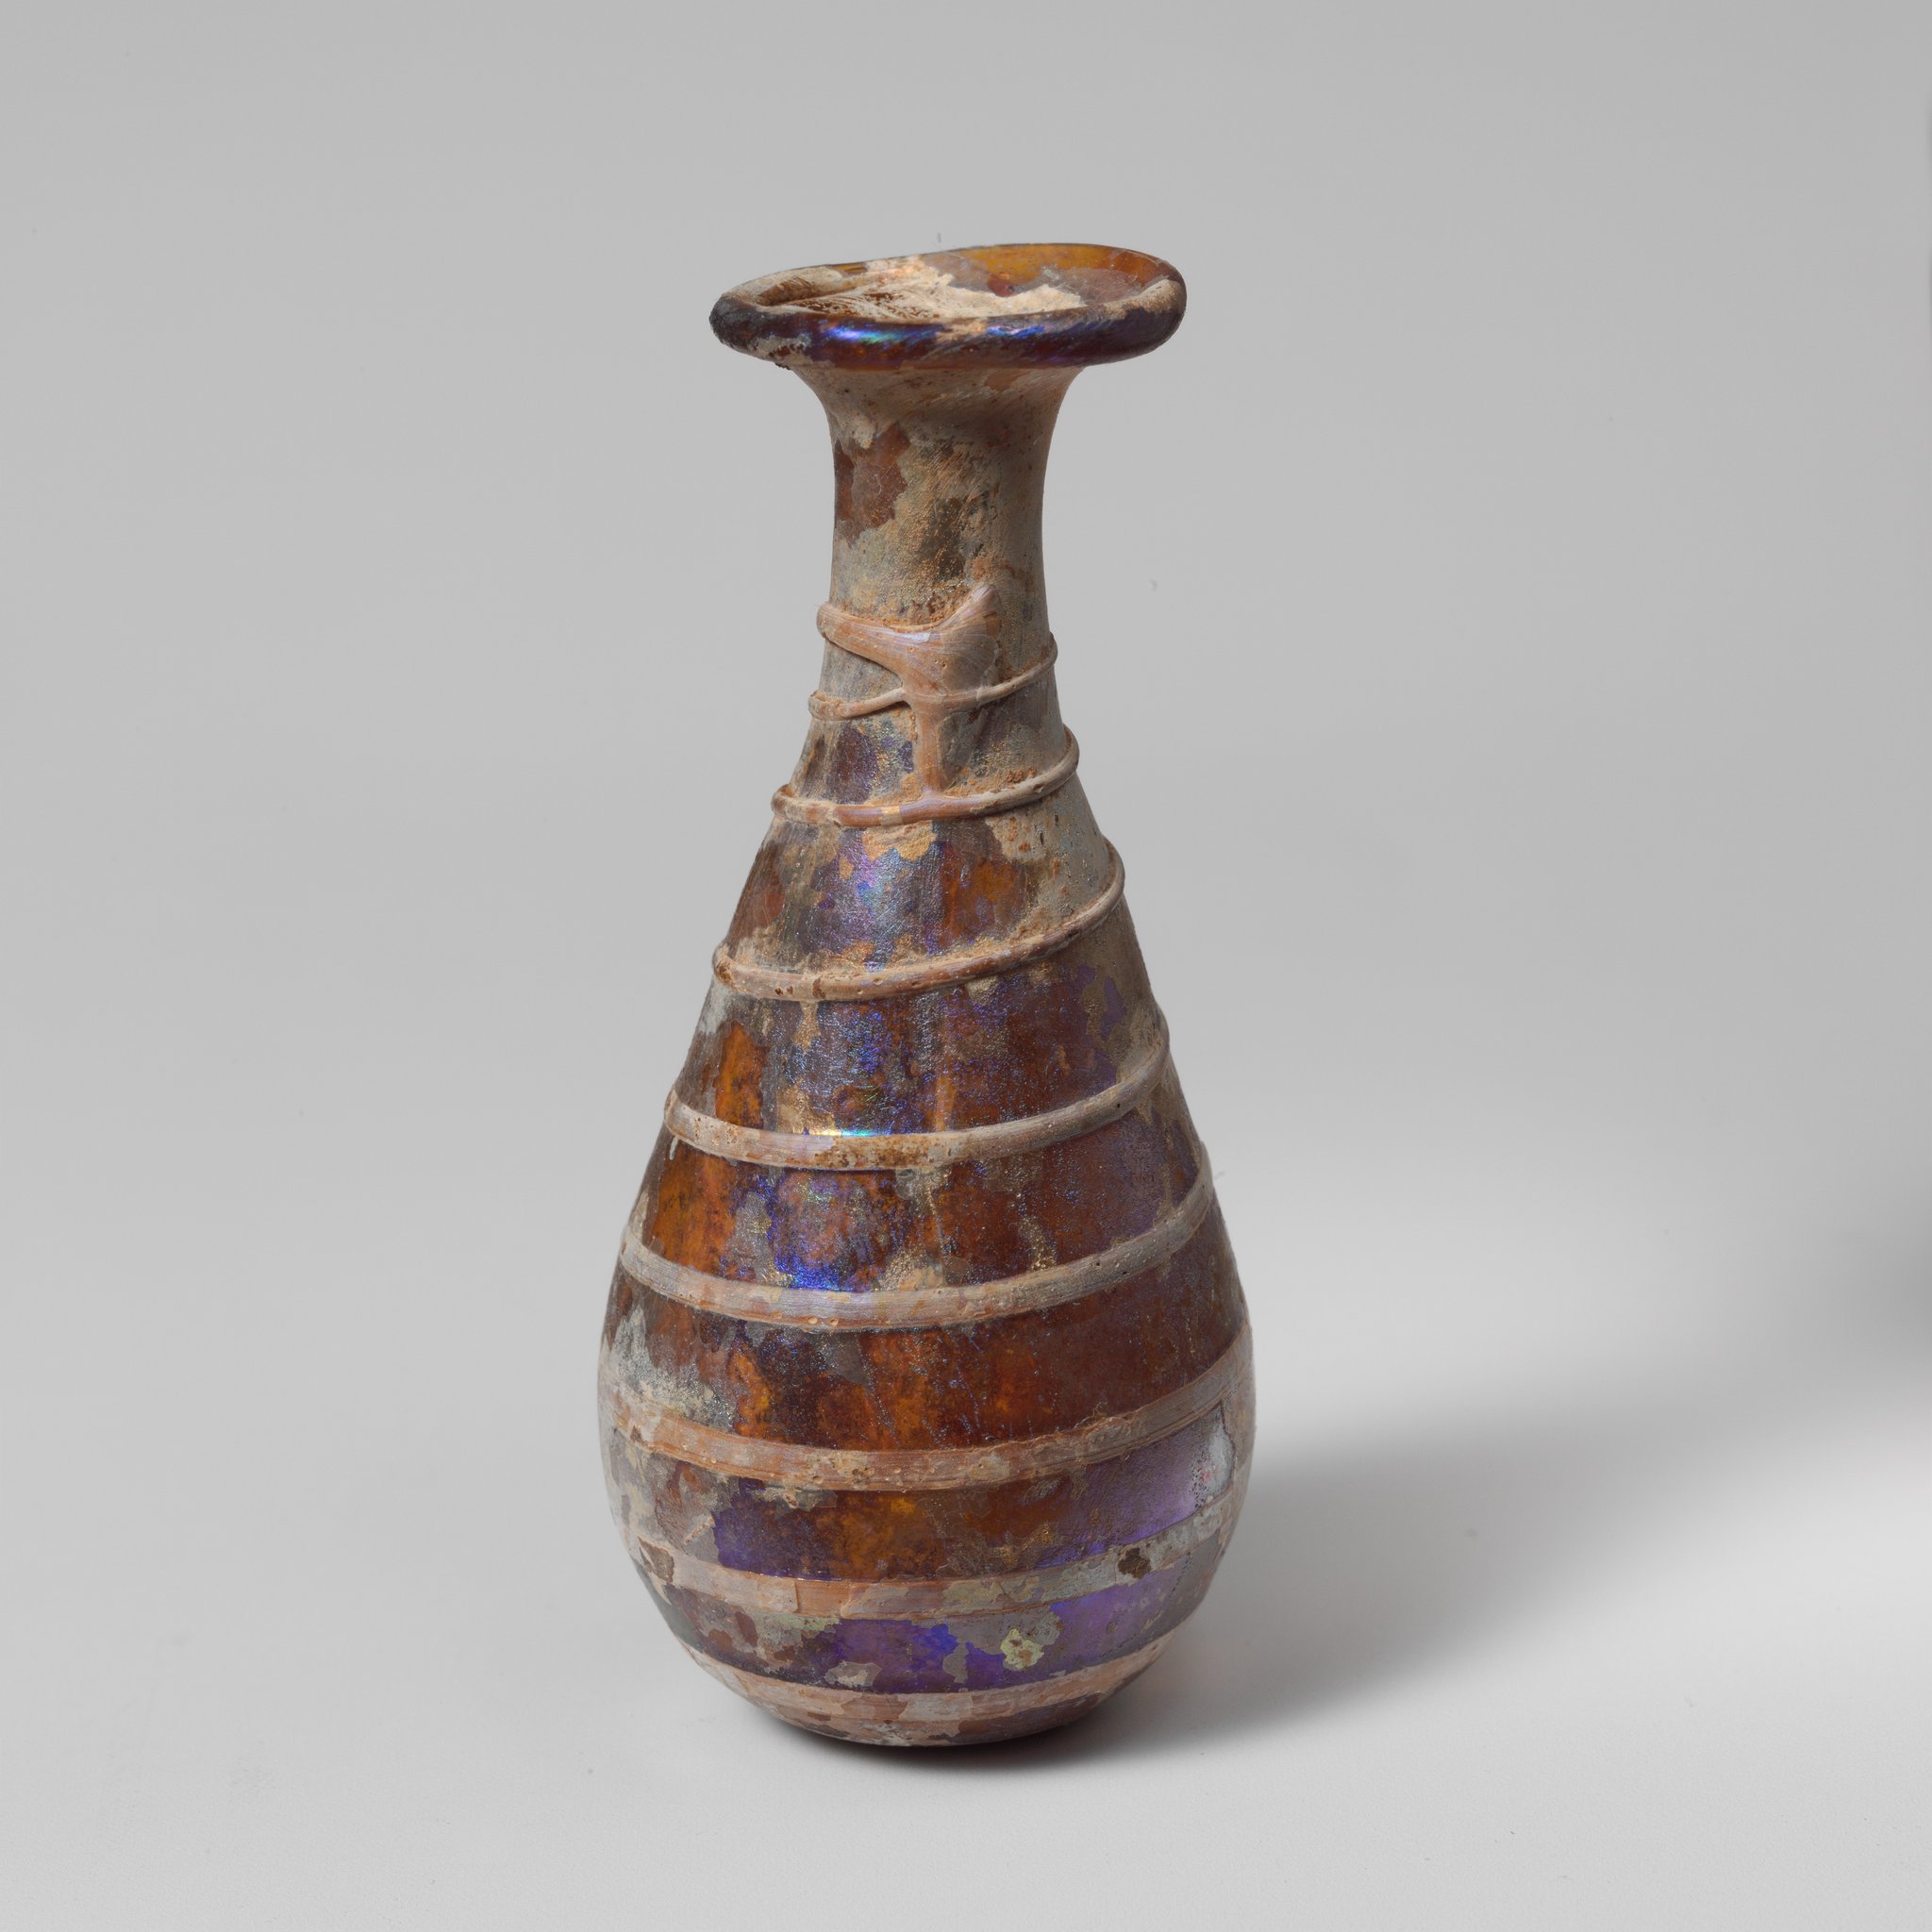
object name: perfume bottle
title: Glass perfume bottle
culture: roman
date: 51-100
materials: glass